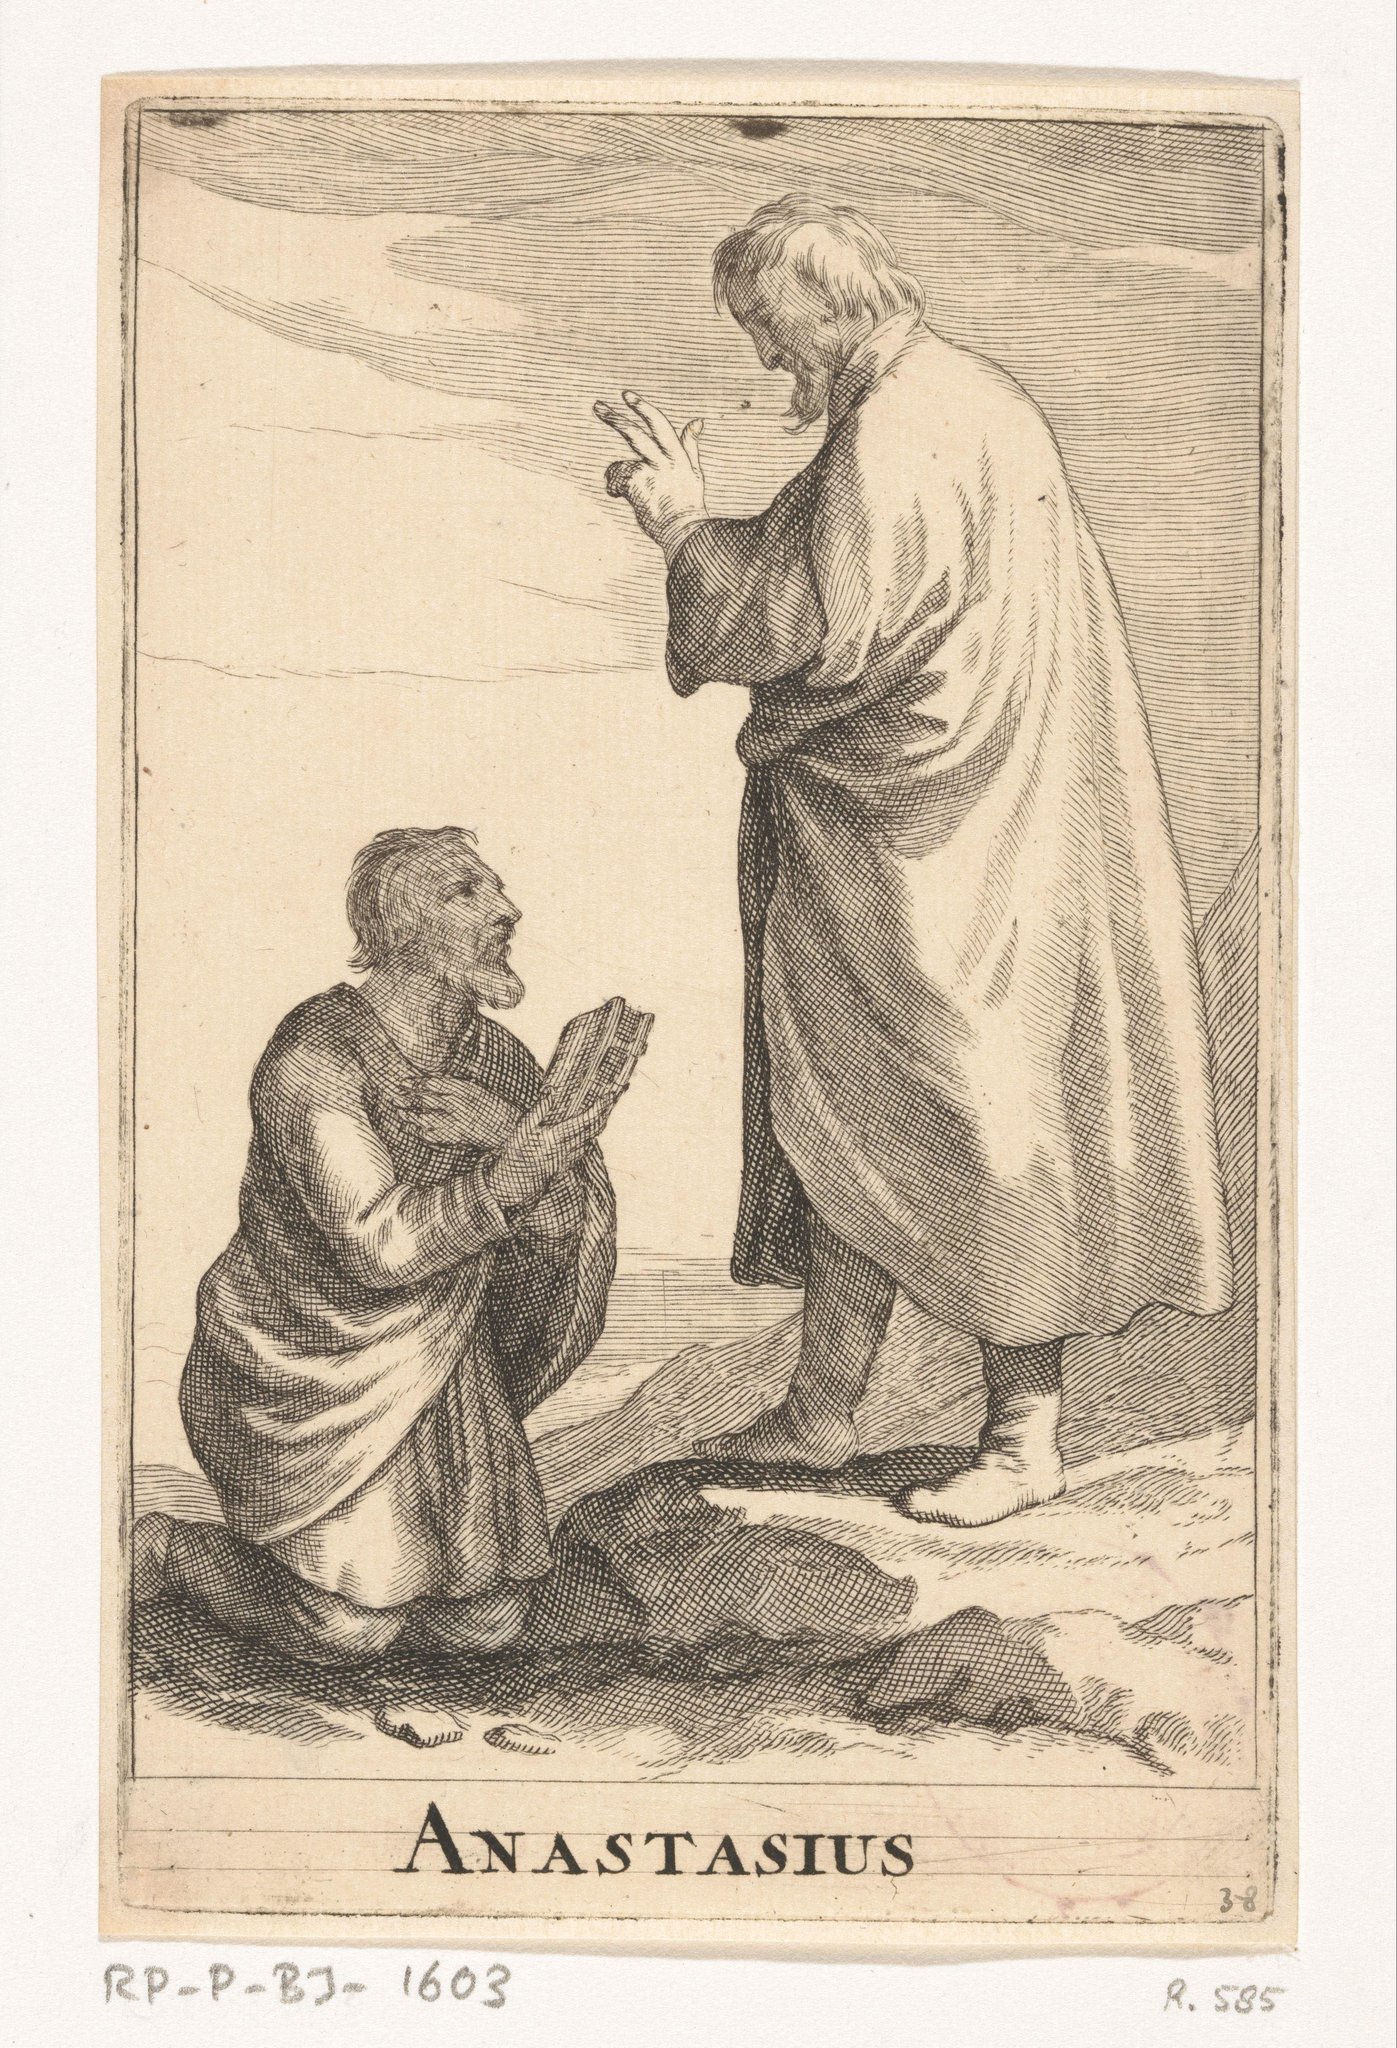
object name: print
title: Anastasius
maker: frederick bloemaert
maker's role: print maker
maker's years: 1614-1669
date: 1636-1670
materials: paper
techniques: engraving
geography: utrecht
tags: male saints (with name)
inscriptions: number: ‘38’, collector's mark: Lugt 240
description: Geknield geeft een dief het door hem gestolen boek aan de heilige Anastatius terug. Prent uit een serie van 80 prenten en een titelprent met kluizenaars uit de 2e tot de 6e eeuw.